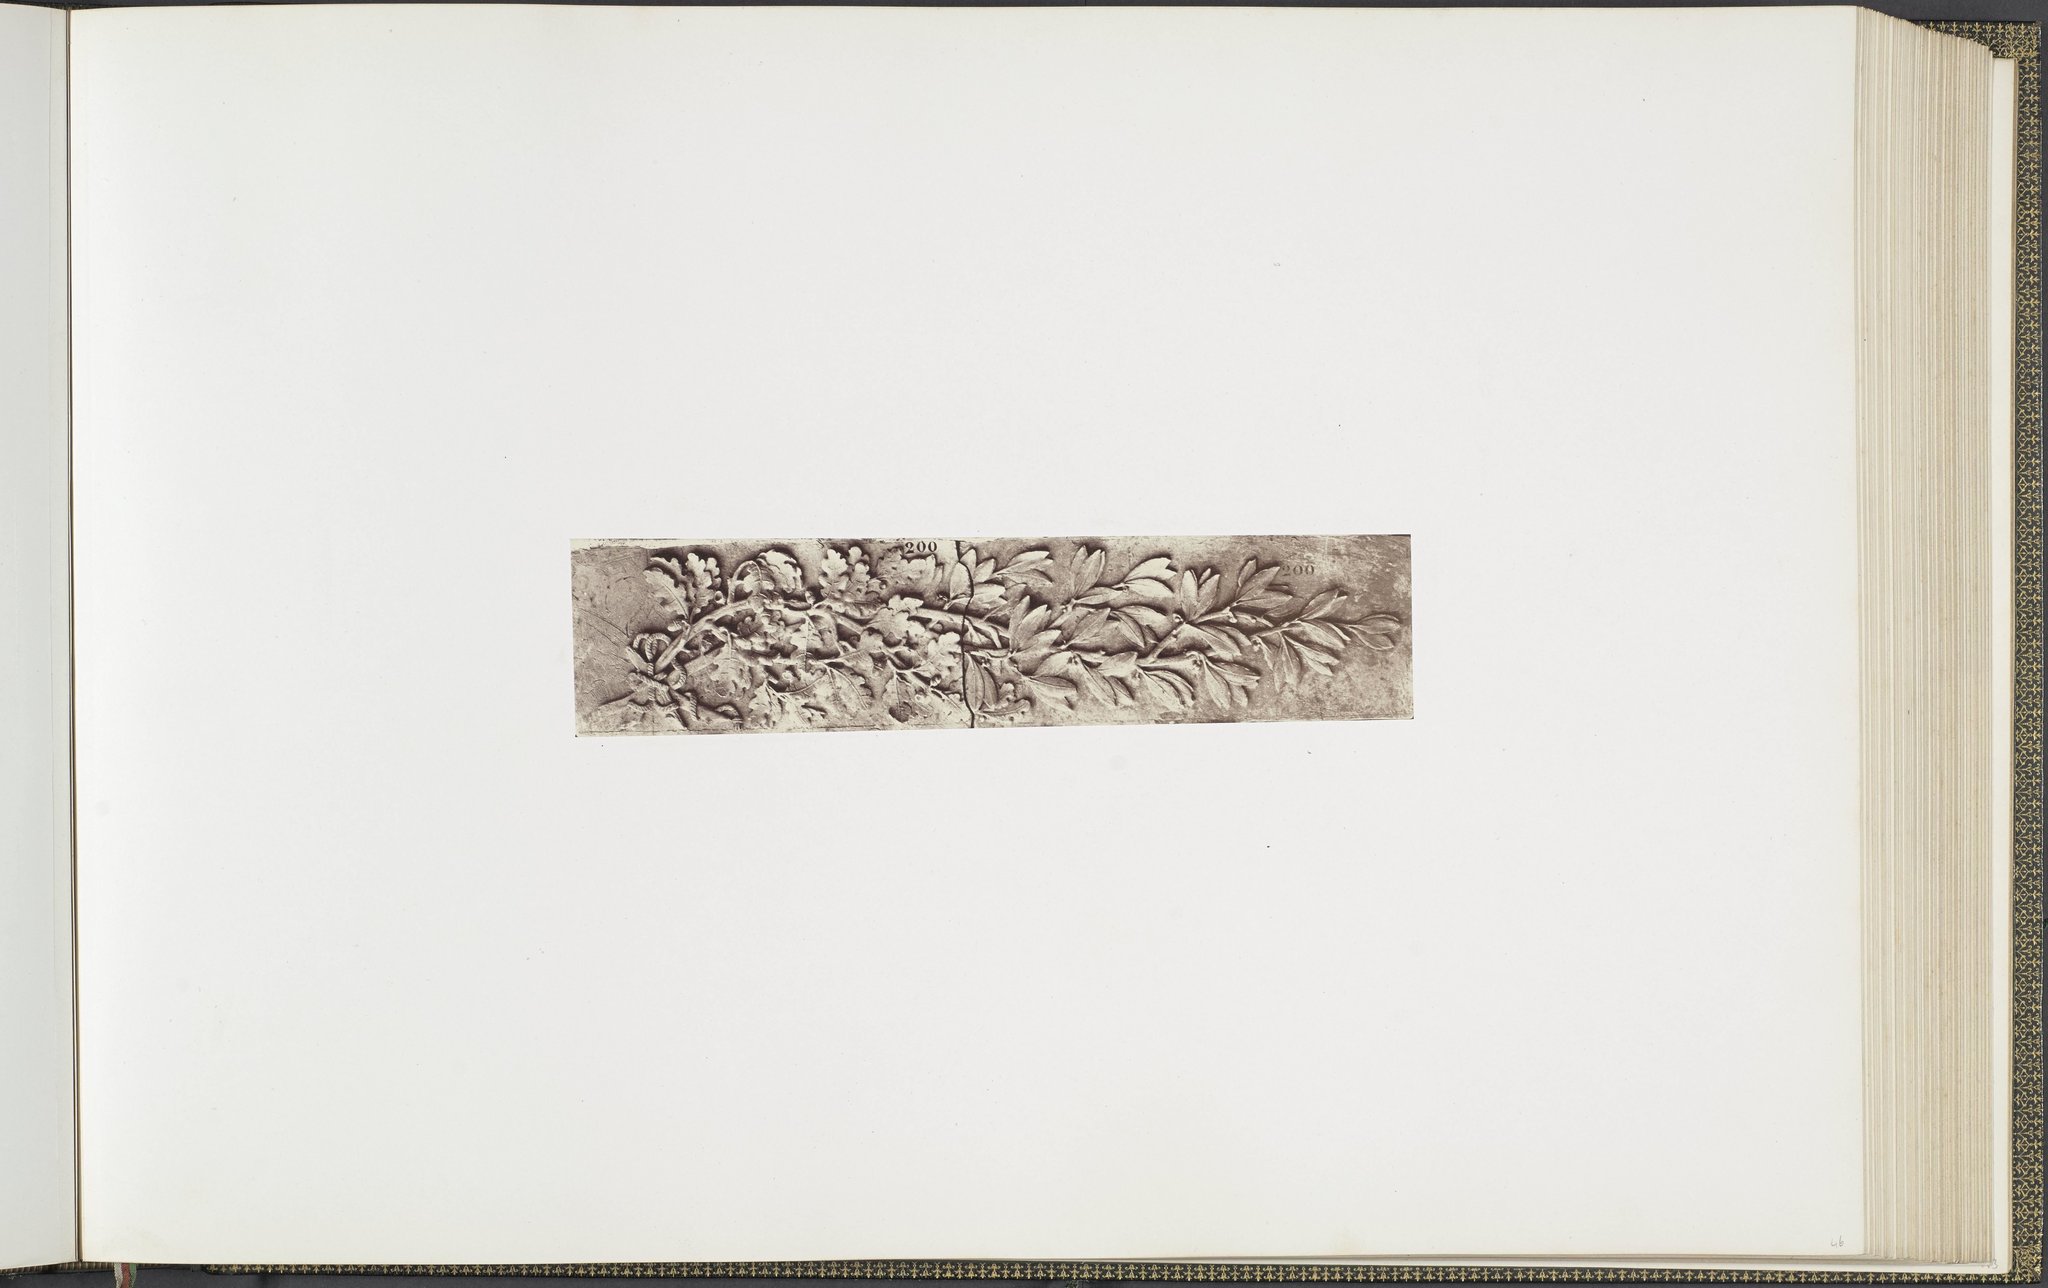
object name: photograph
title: Detail van een gipsmodel voor het fries op het Palais du Louvre door Léon Falconnier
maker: édouard denis baldus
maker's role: fotograaf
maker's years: 1813-1889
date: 1855-1857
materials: paper, photographic support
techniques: salted paper print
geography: paris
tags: permanent exhibition, museum, ornamenting, decorating ~ applied arts, paris, tuileries palace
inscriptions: number: ‘200’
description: Onderdeel van Réunion des Tuileries au Louvre 1852-1857, album 1.